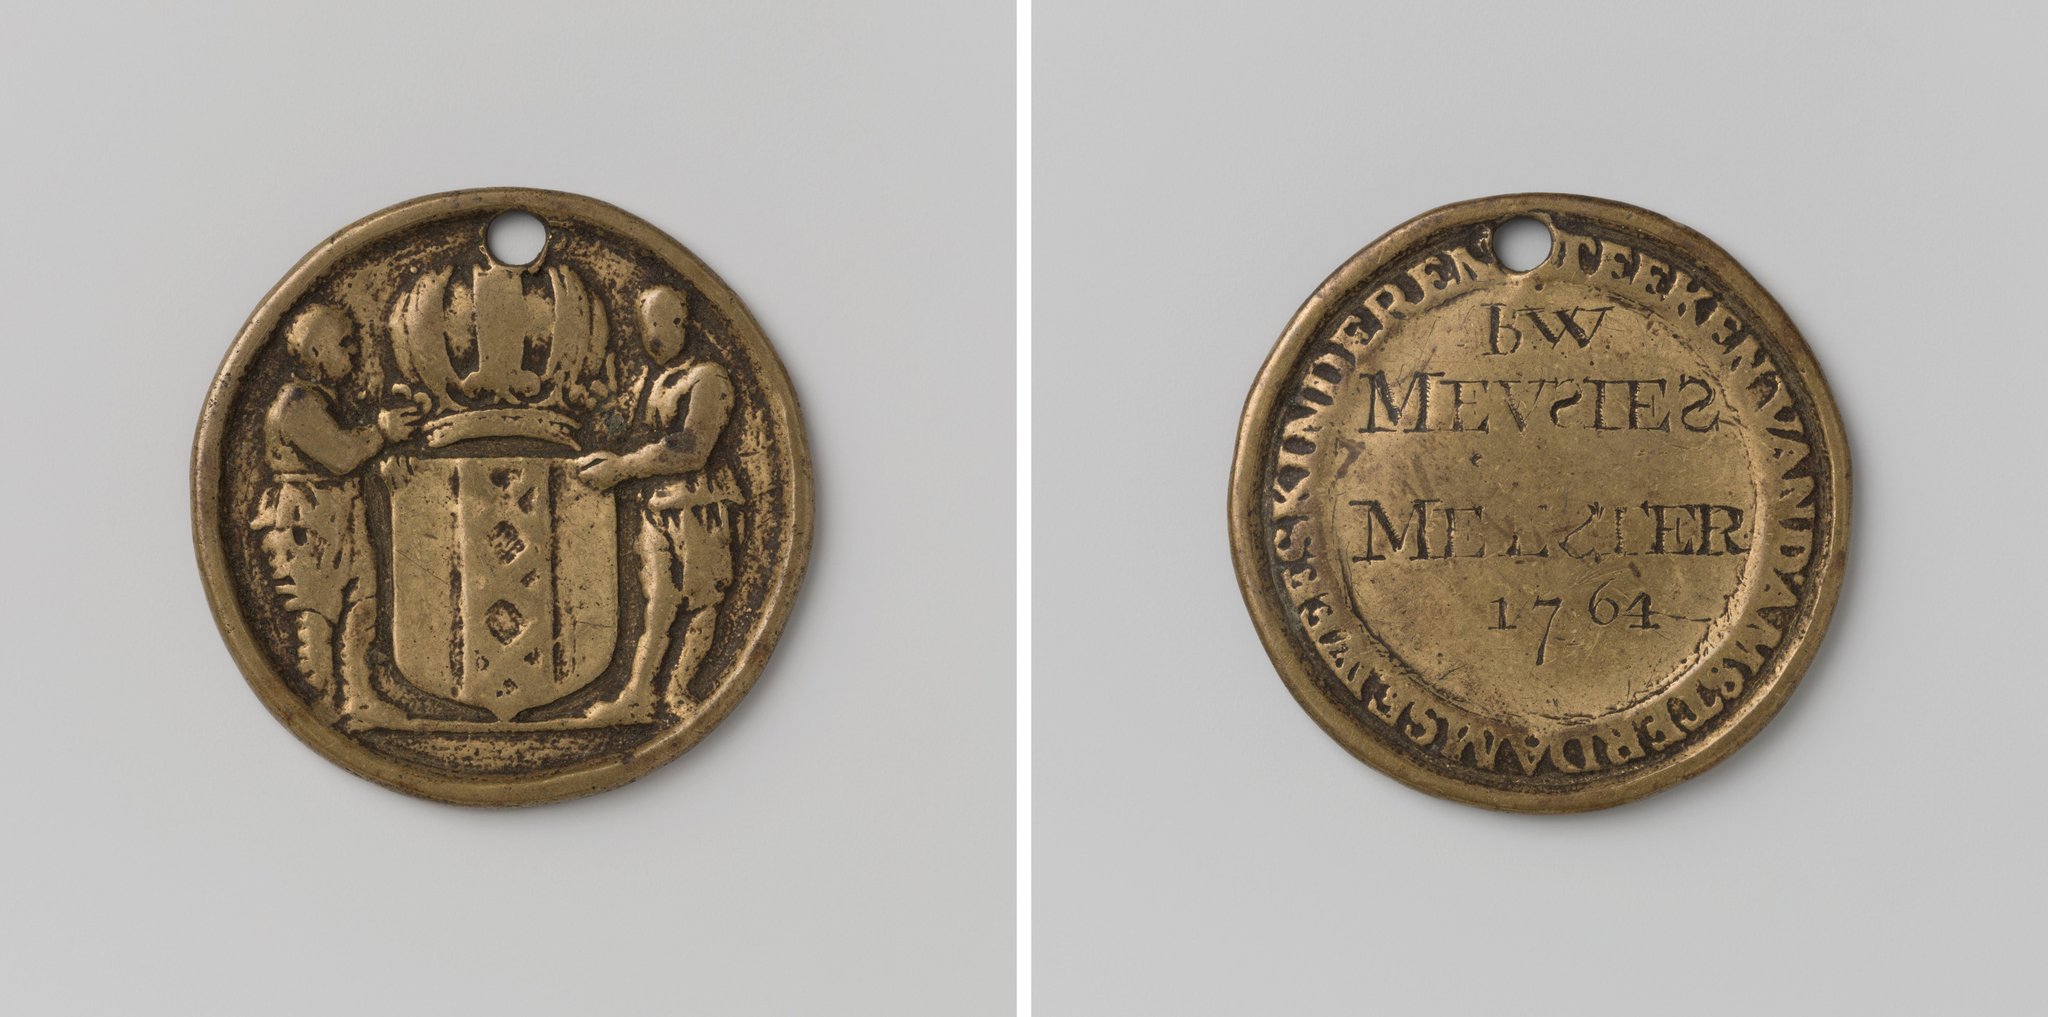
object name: medal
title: Burgerweeshuis te Amsterdam, penning van meester B.W. Meusies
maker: Anonymous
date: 1764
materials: brass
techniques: casting, engraving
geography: amsterdam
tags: b.w. meusies, burgerweeshuis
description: Messing penning met gat erin. Voorzijde: gekroond wapenschild, geflankeerd door twee weeskinderen. Keerzijde: opschrift binnen omschrift